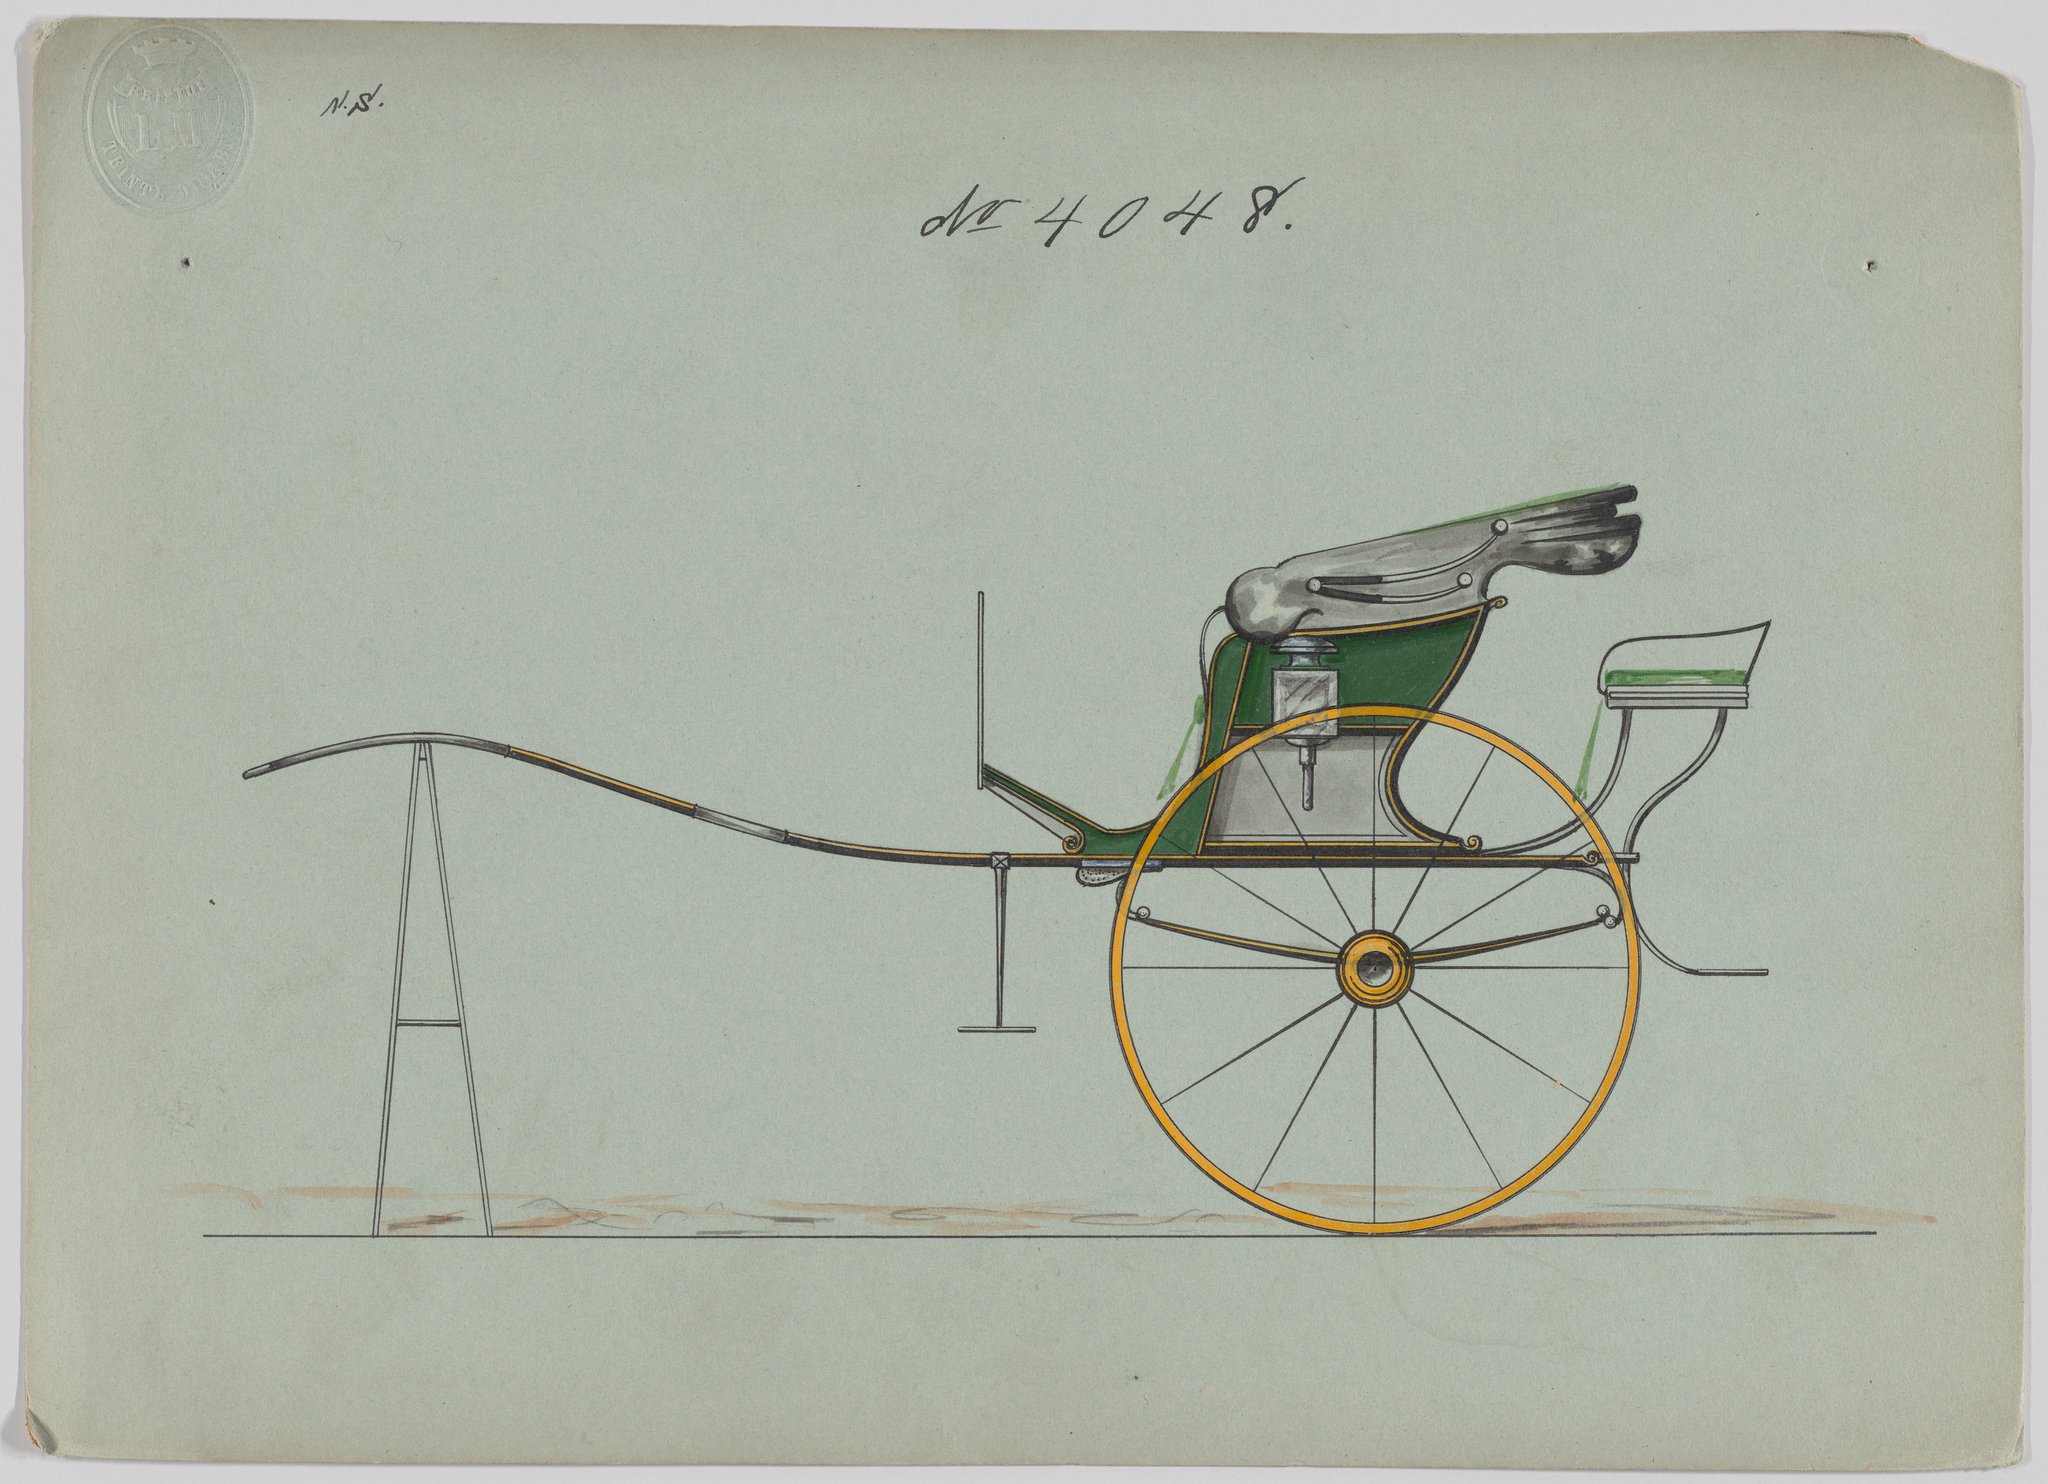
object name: drawing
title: Design for Dog Cart or 2 Wheeler, no. 4048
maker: brewster & co.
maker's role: manufacturer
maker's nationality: american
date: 1889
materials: gouache, gum arabic, ink, watercolor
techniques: pen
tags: carriages